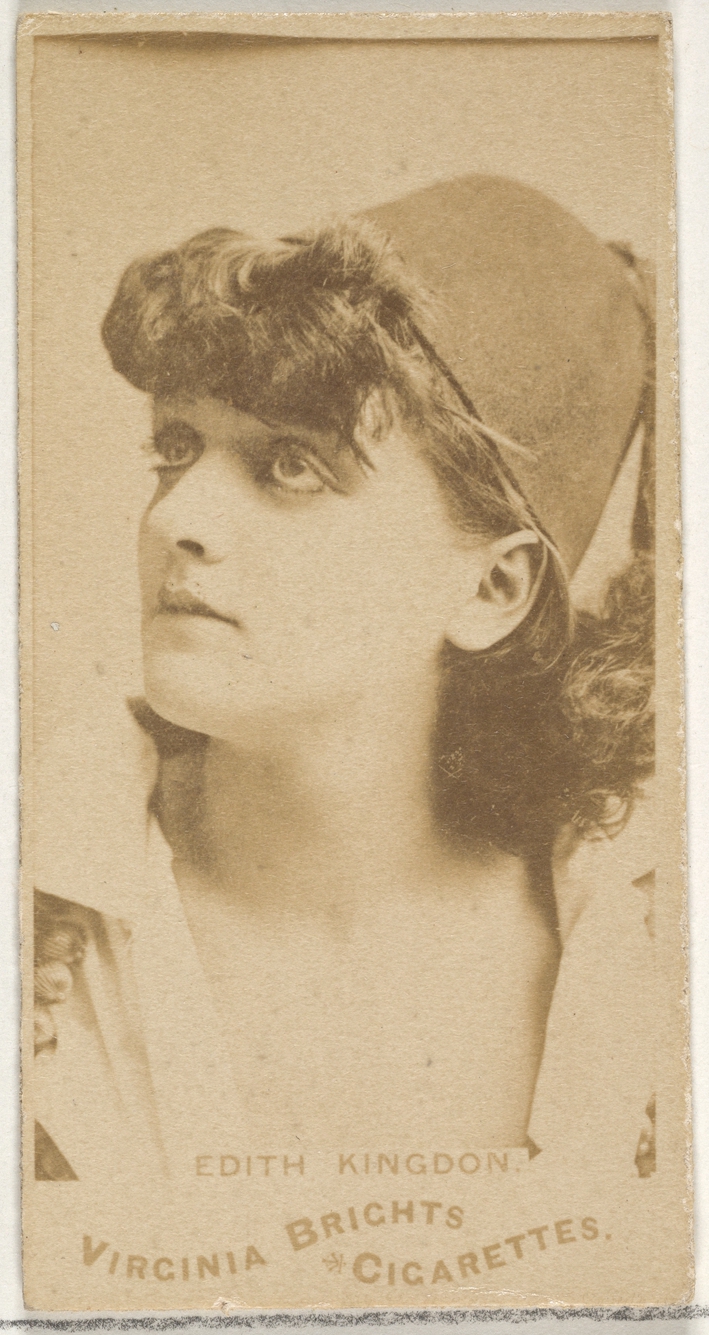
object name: photograph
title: Edith Kingdon, from the Actors and Actresses series (N45, Type 1) for Virginia Brights Cigarettes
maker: allen & ginter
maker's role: publisher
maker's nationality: american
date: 1888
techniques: albumen silver print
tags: portraits,women,actresses